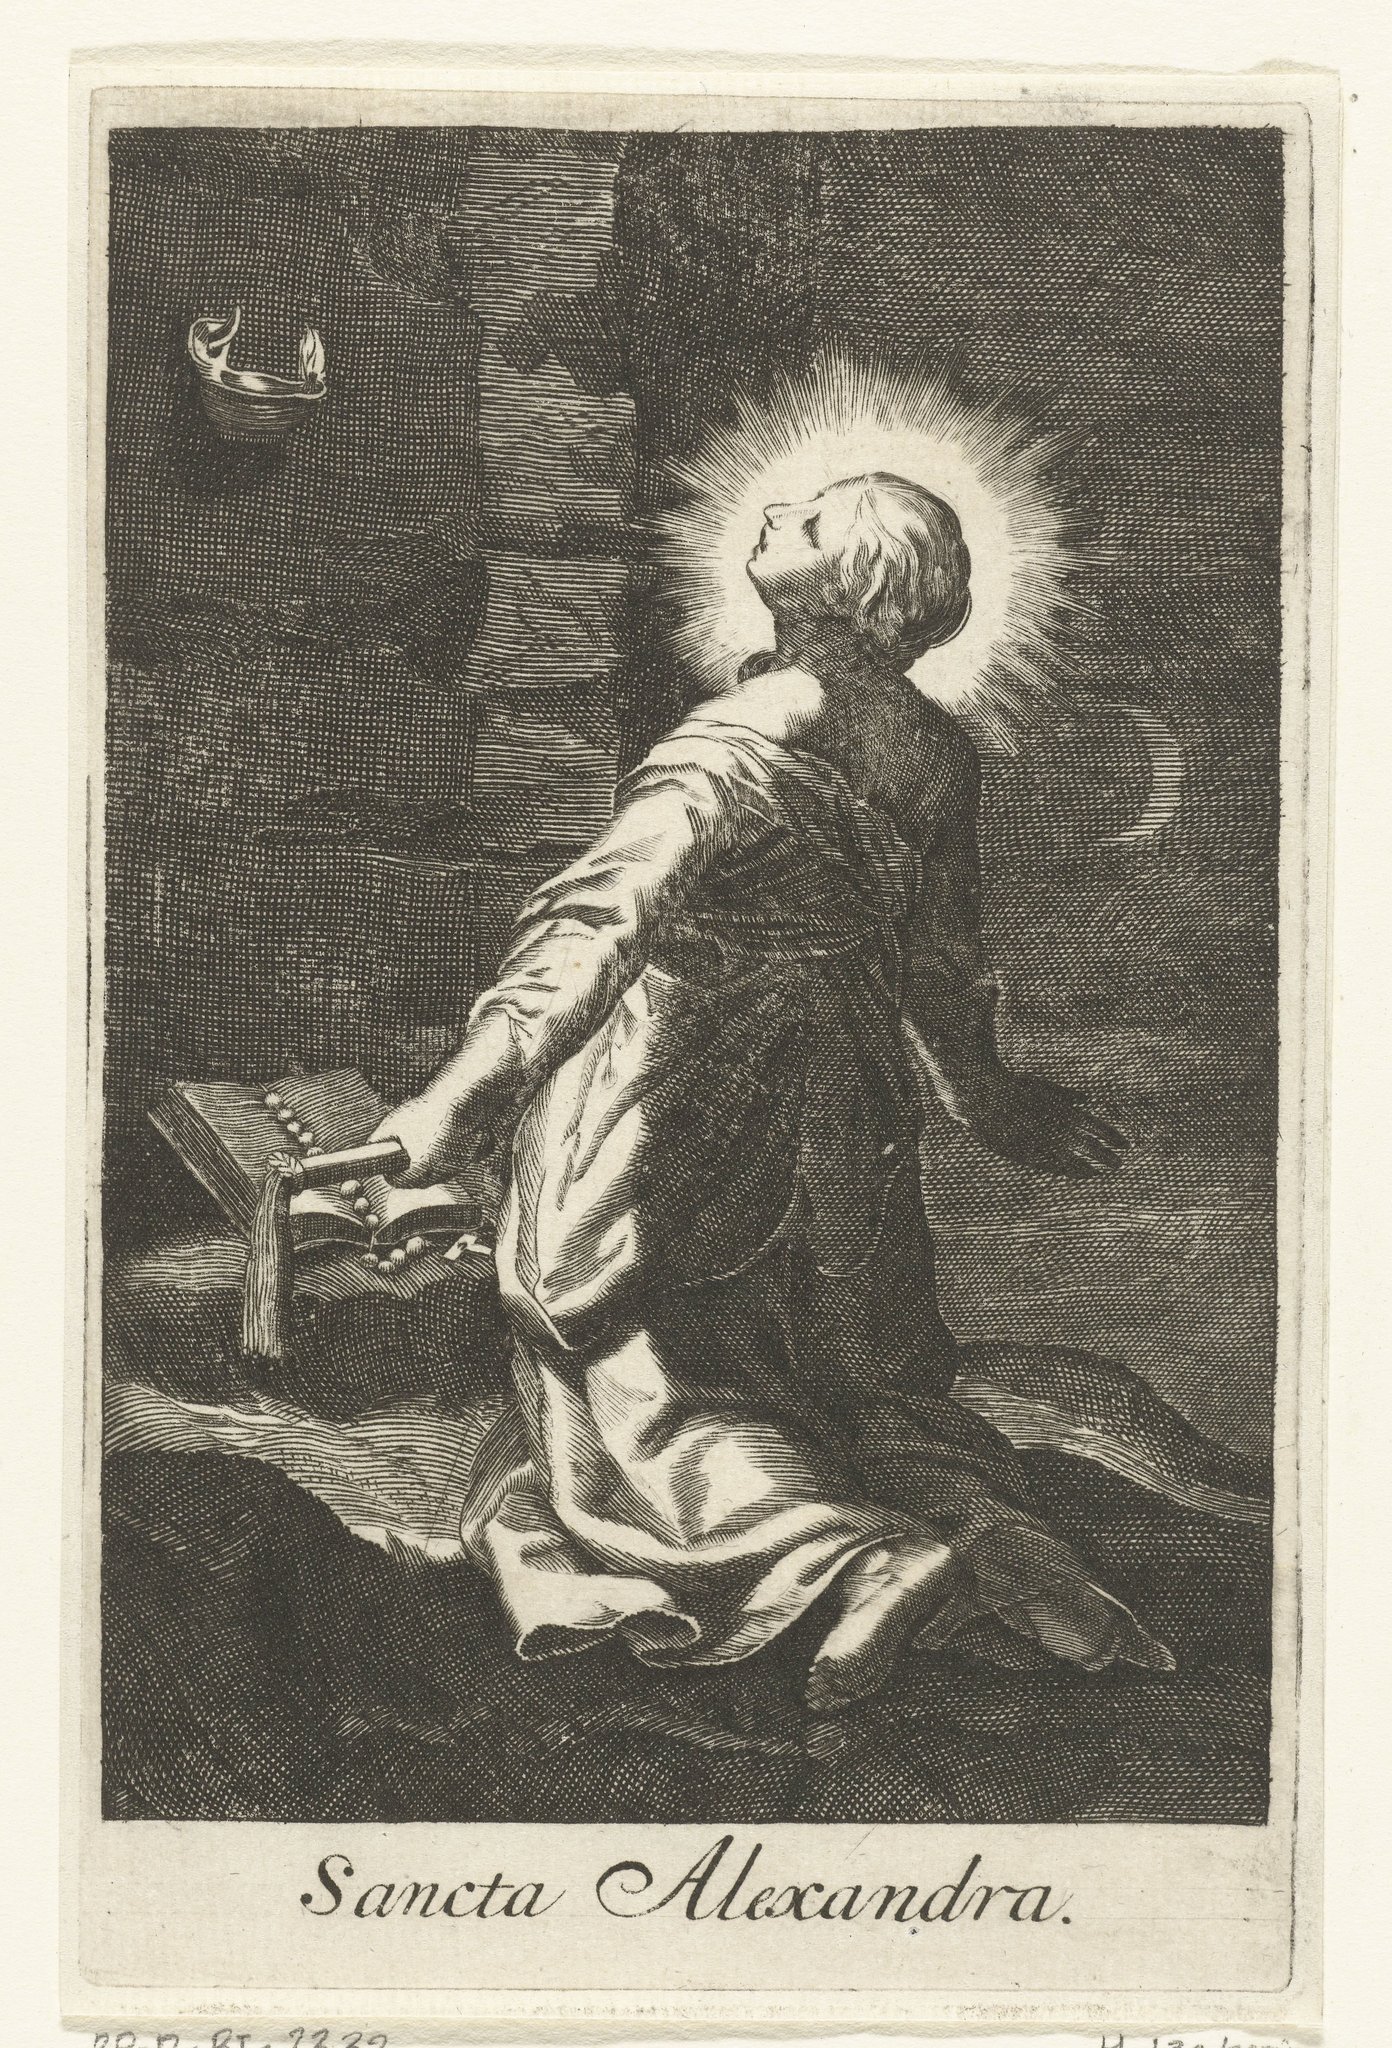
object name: print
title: Heilige Alexandra als kluizenares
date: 1590-1662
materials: paper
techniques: engraving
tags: anchorite, hermit, female saints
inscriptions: collector's mark: Lugt 2228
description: Kopie in spiegelbeeld naar prent van Boëtius Adamsz. Bolswert uit serie Kluizenaressen.